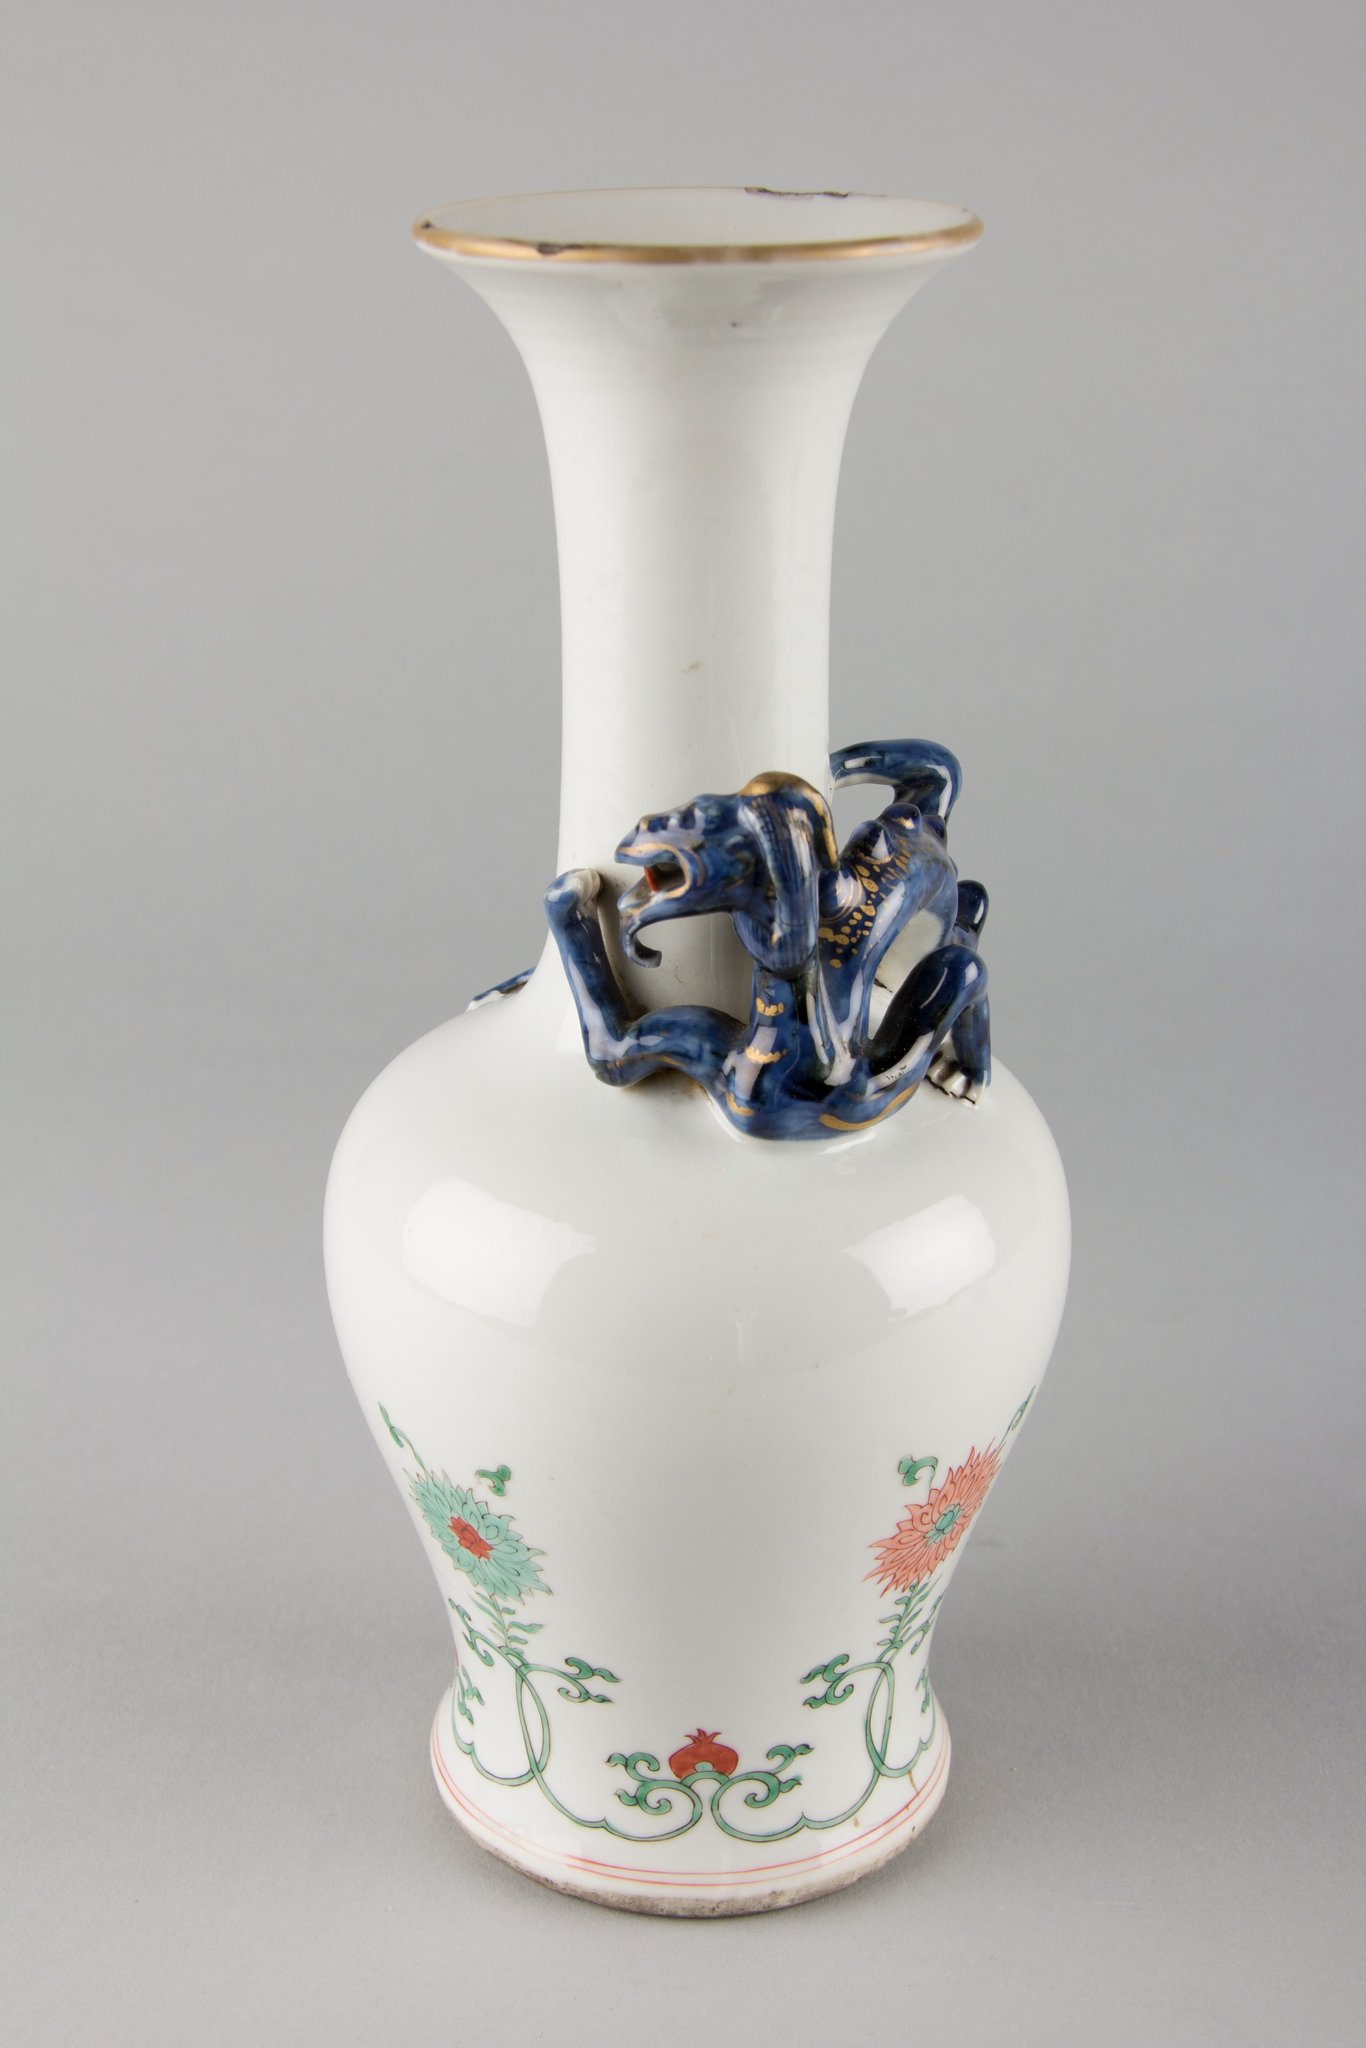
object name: vase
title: Vase with entwined dragon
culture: chinese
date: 1667-1733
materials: enamel, gilt, glaze, porcelain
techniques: overglaze, painting, polychrome, relief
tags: dragons,flowers